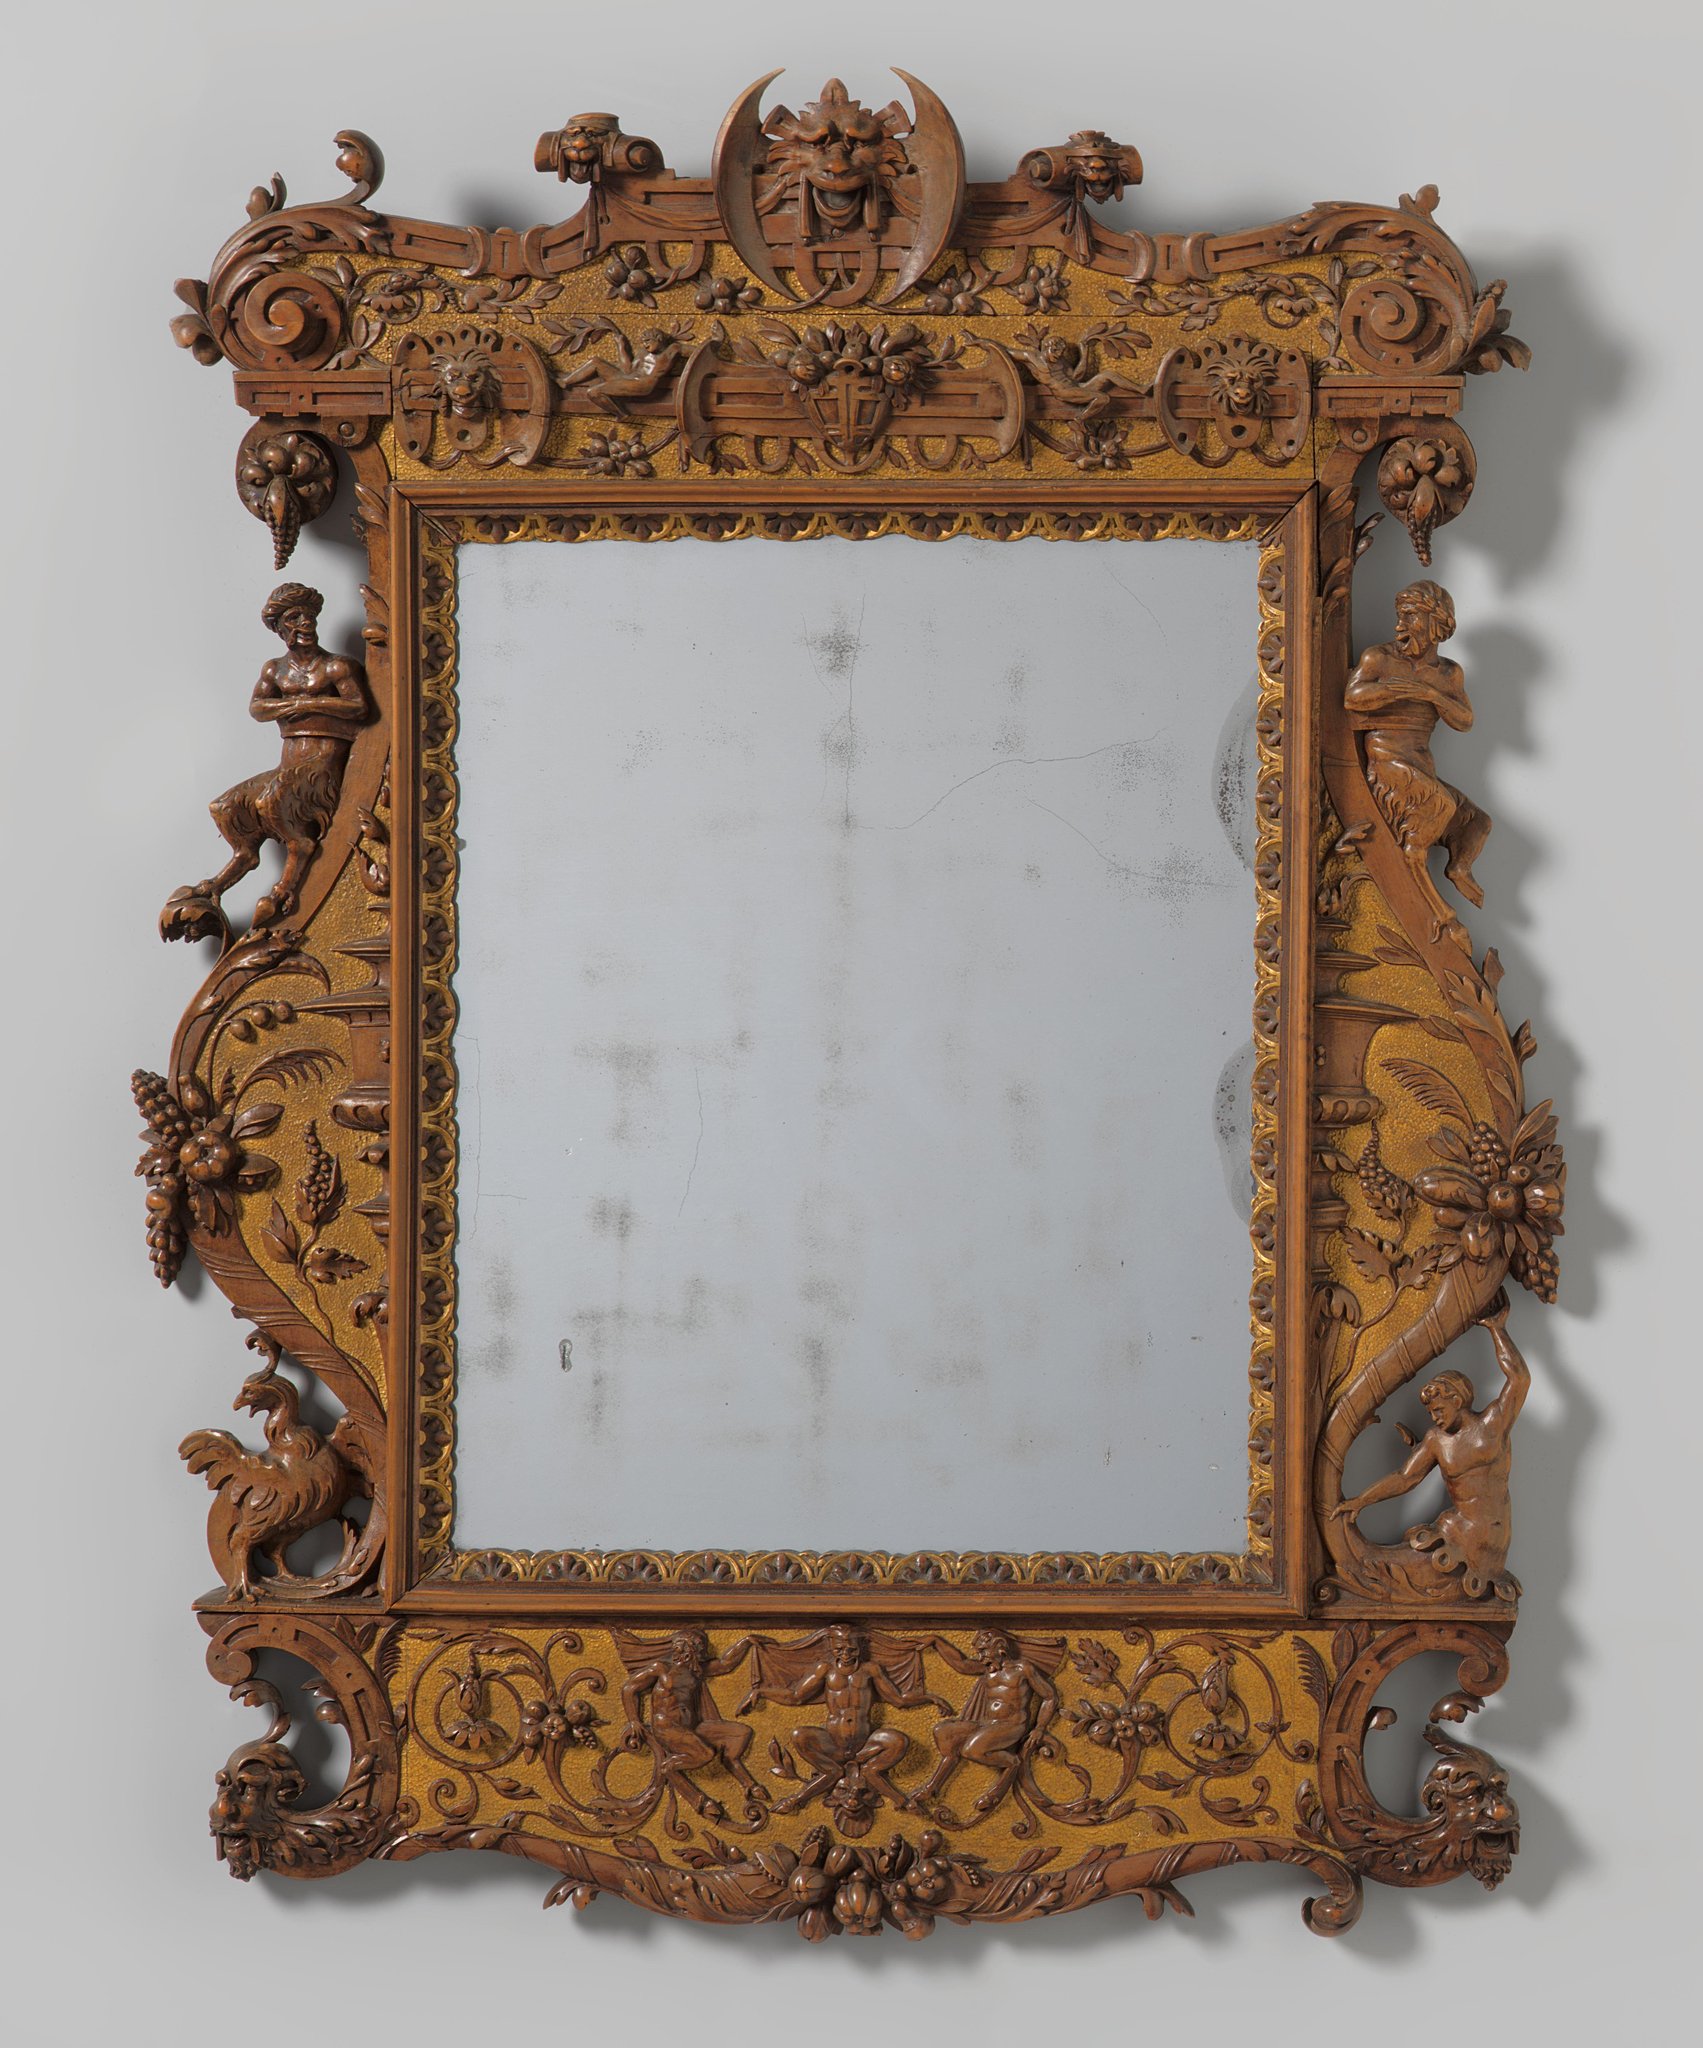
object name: decoratief object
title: Spiegellijst van palmhout met gesneden versiering met o.a. grotesken, voluten, saters, een basilisk en een triton, bloemen en ranken en maskers.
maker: Anonymous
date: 1540-1560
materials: amalgam, wood, glass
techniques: gilding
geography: southern netherlands